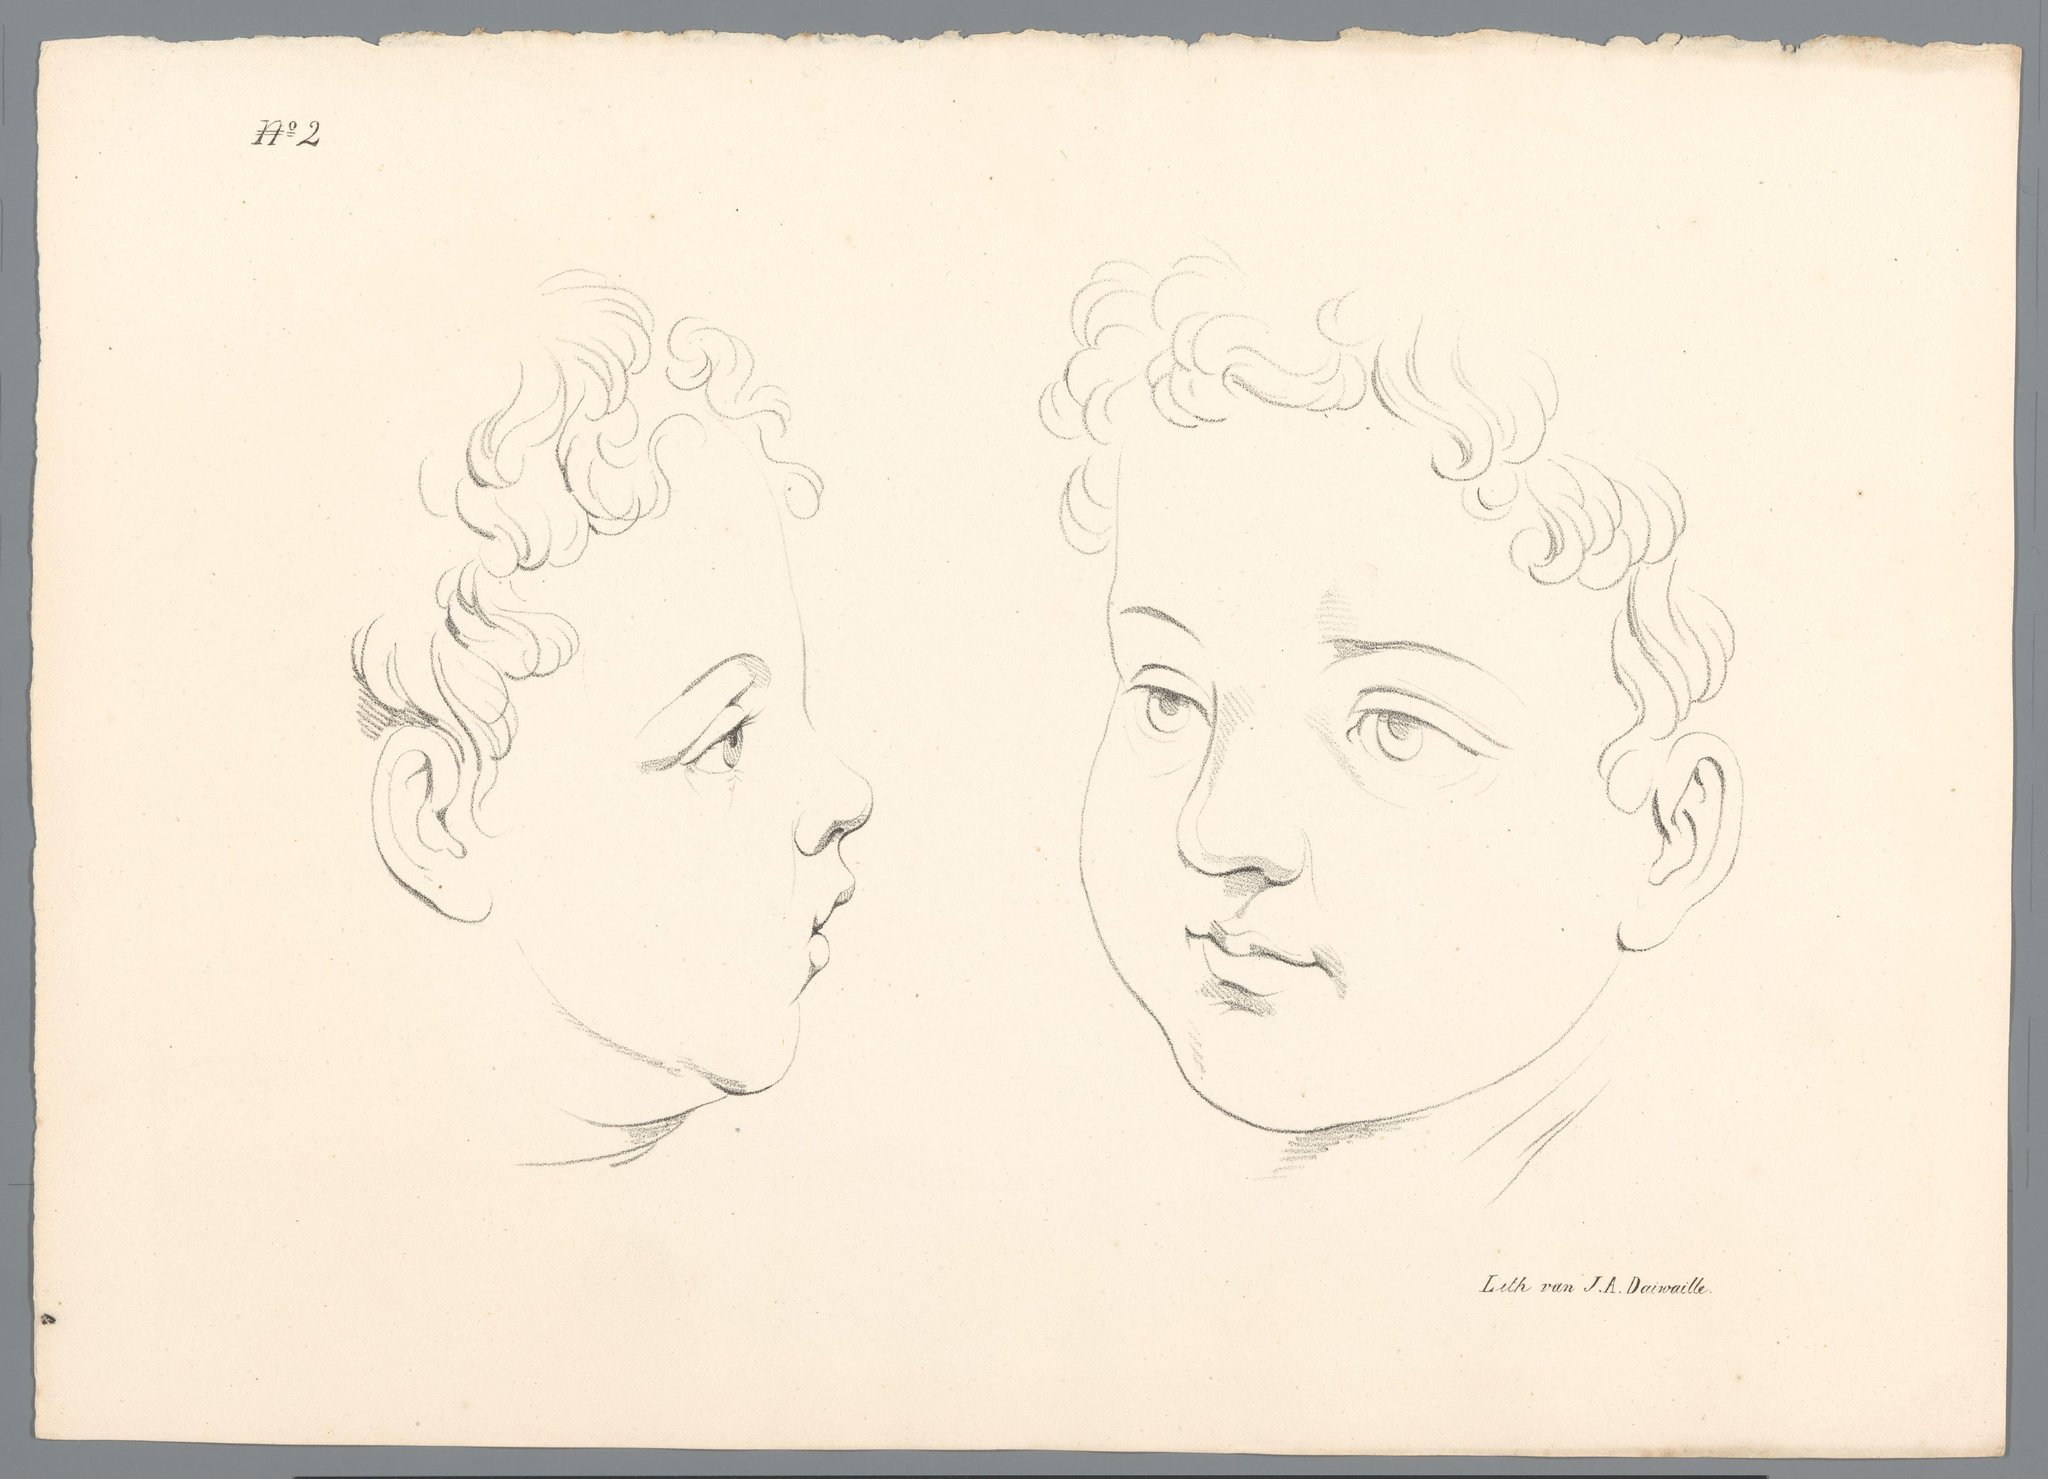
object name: print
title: Beeld-studien voor Eerstbeginnende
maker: jean augustin daiwaille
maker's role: draughtsman, print maker, printer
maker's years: 1786-1850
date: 1820-1826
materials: paper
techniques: lithograph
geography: amsterdam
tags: head (human) (+ three-quarter view), head (human) (+ sideview, profile), child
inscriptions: collector's mark: Lugt 2228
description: Het hoofd links is en profiel afgebeeld, het hoofd rechts a trois quart. Het kind heeft kort gekruld haar. Genummerd linksboven: 'No. 2'. Deze prent maakt deel uit van een omslag met veertien prenten.